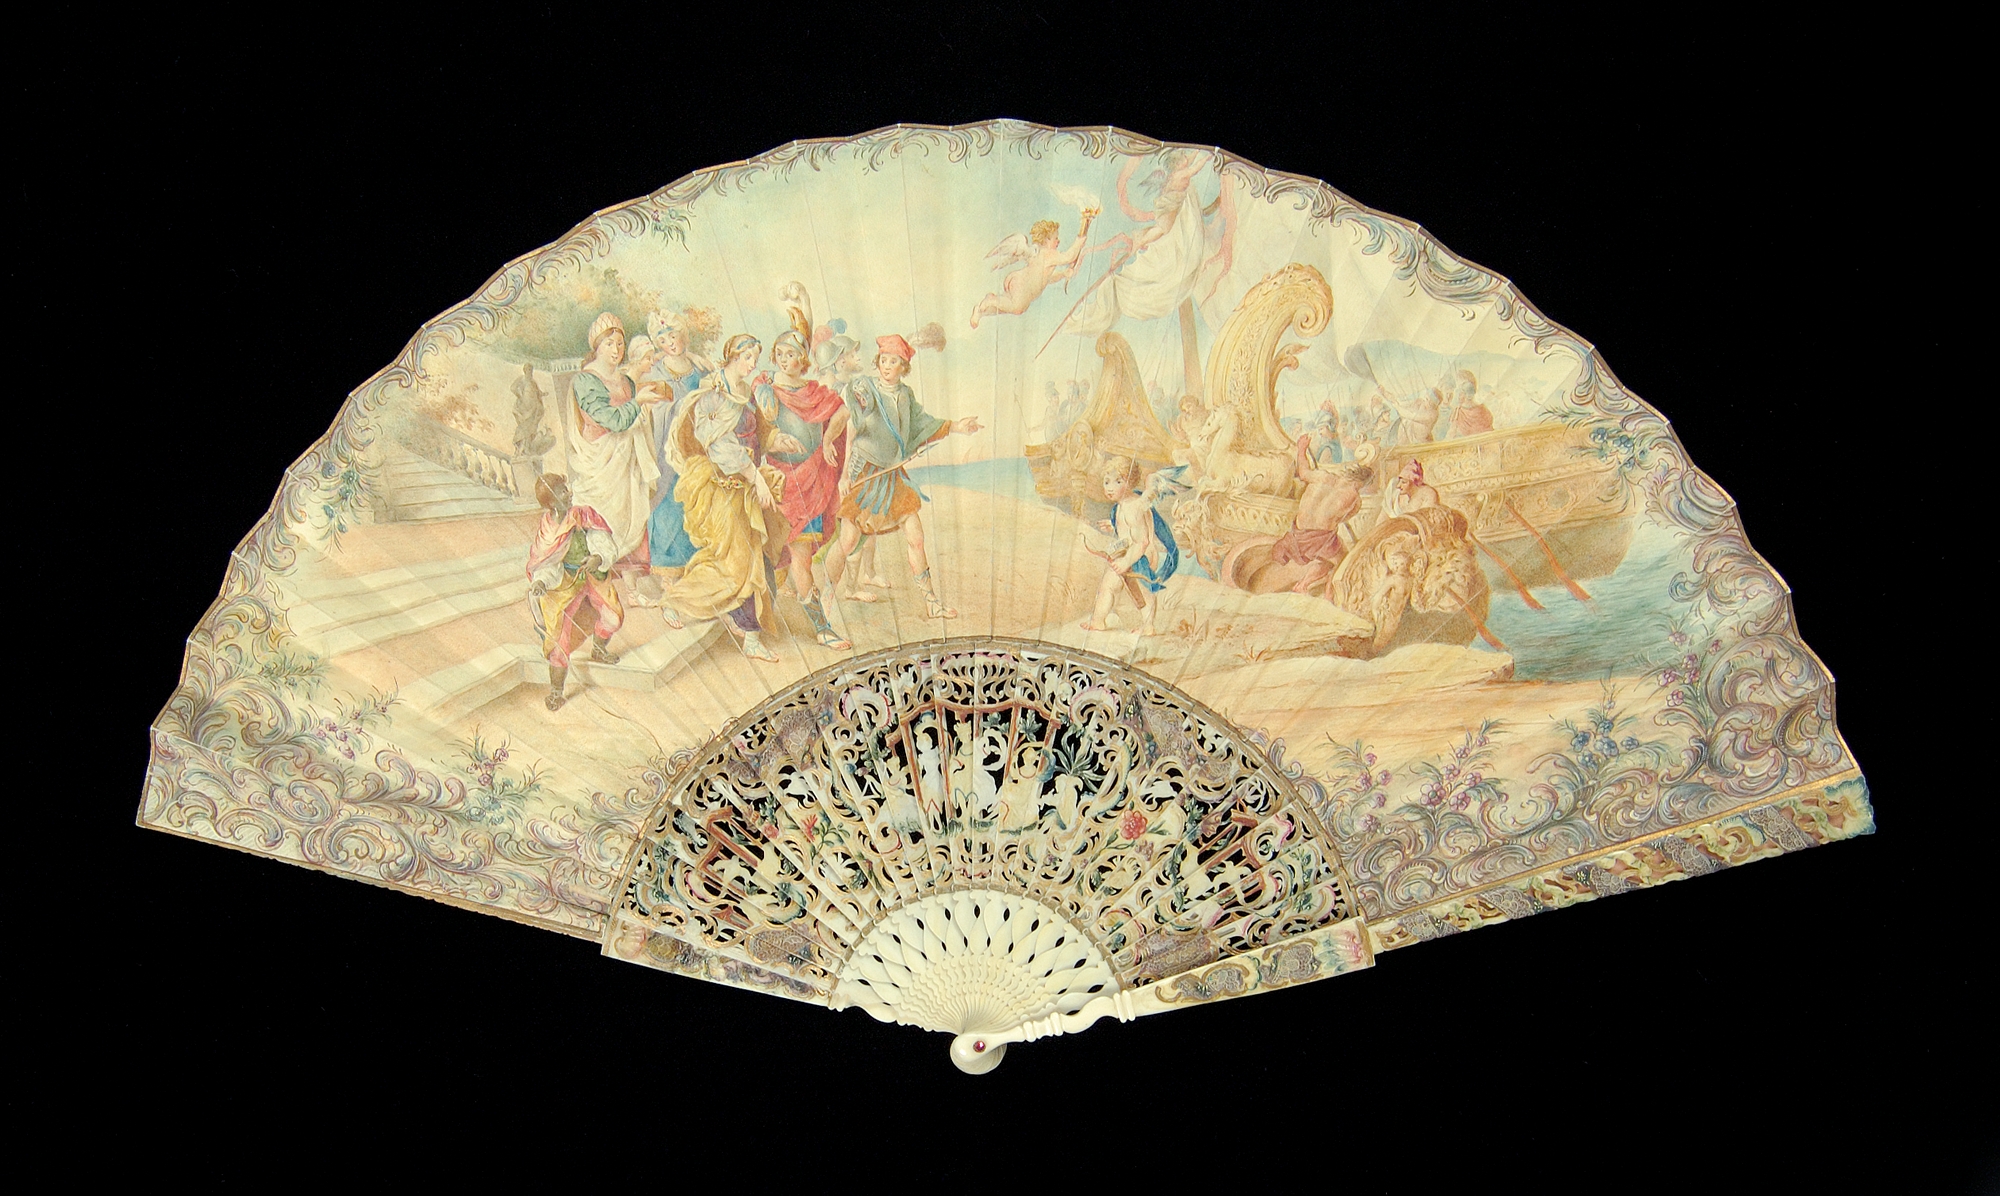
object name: fan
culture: european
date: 1826-1850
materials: ivory, parchment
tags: men,women,cupid,ships